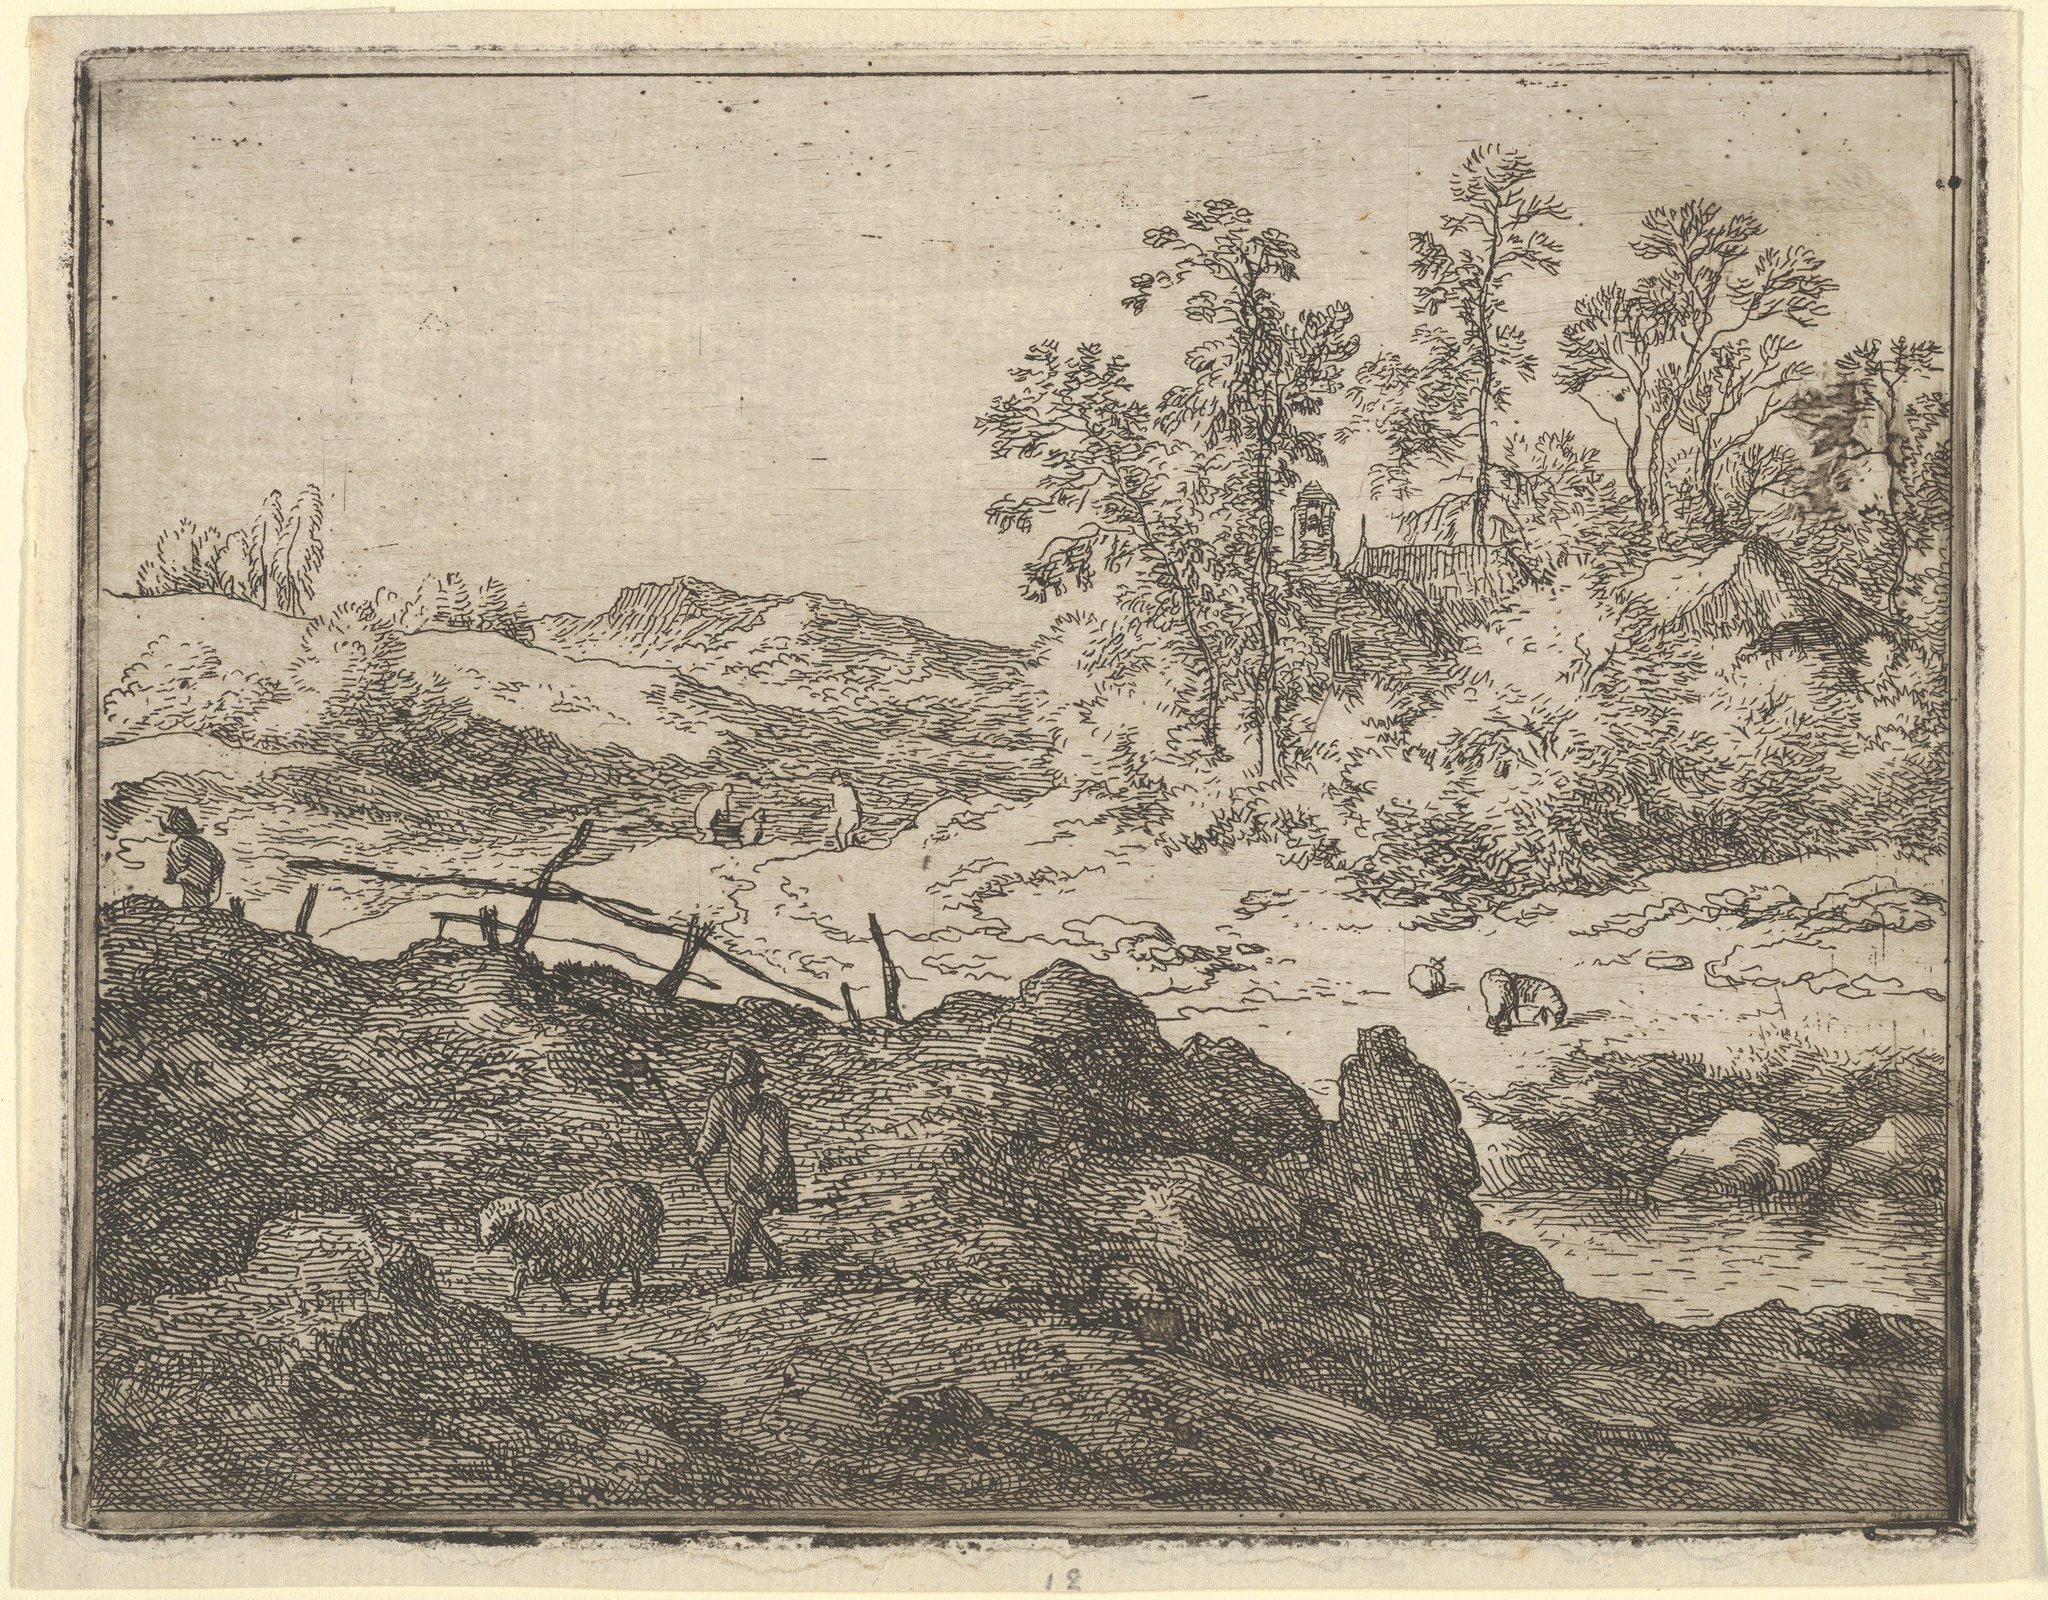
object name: print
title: The Shepherd and the Lamb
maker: allart van everdingen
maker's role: artist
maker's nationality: dutch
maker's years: 1621-1675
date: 1621-1675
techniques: engraving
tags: men,lambs,landscapes,trees,shepherds